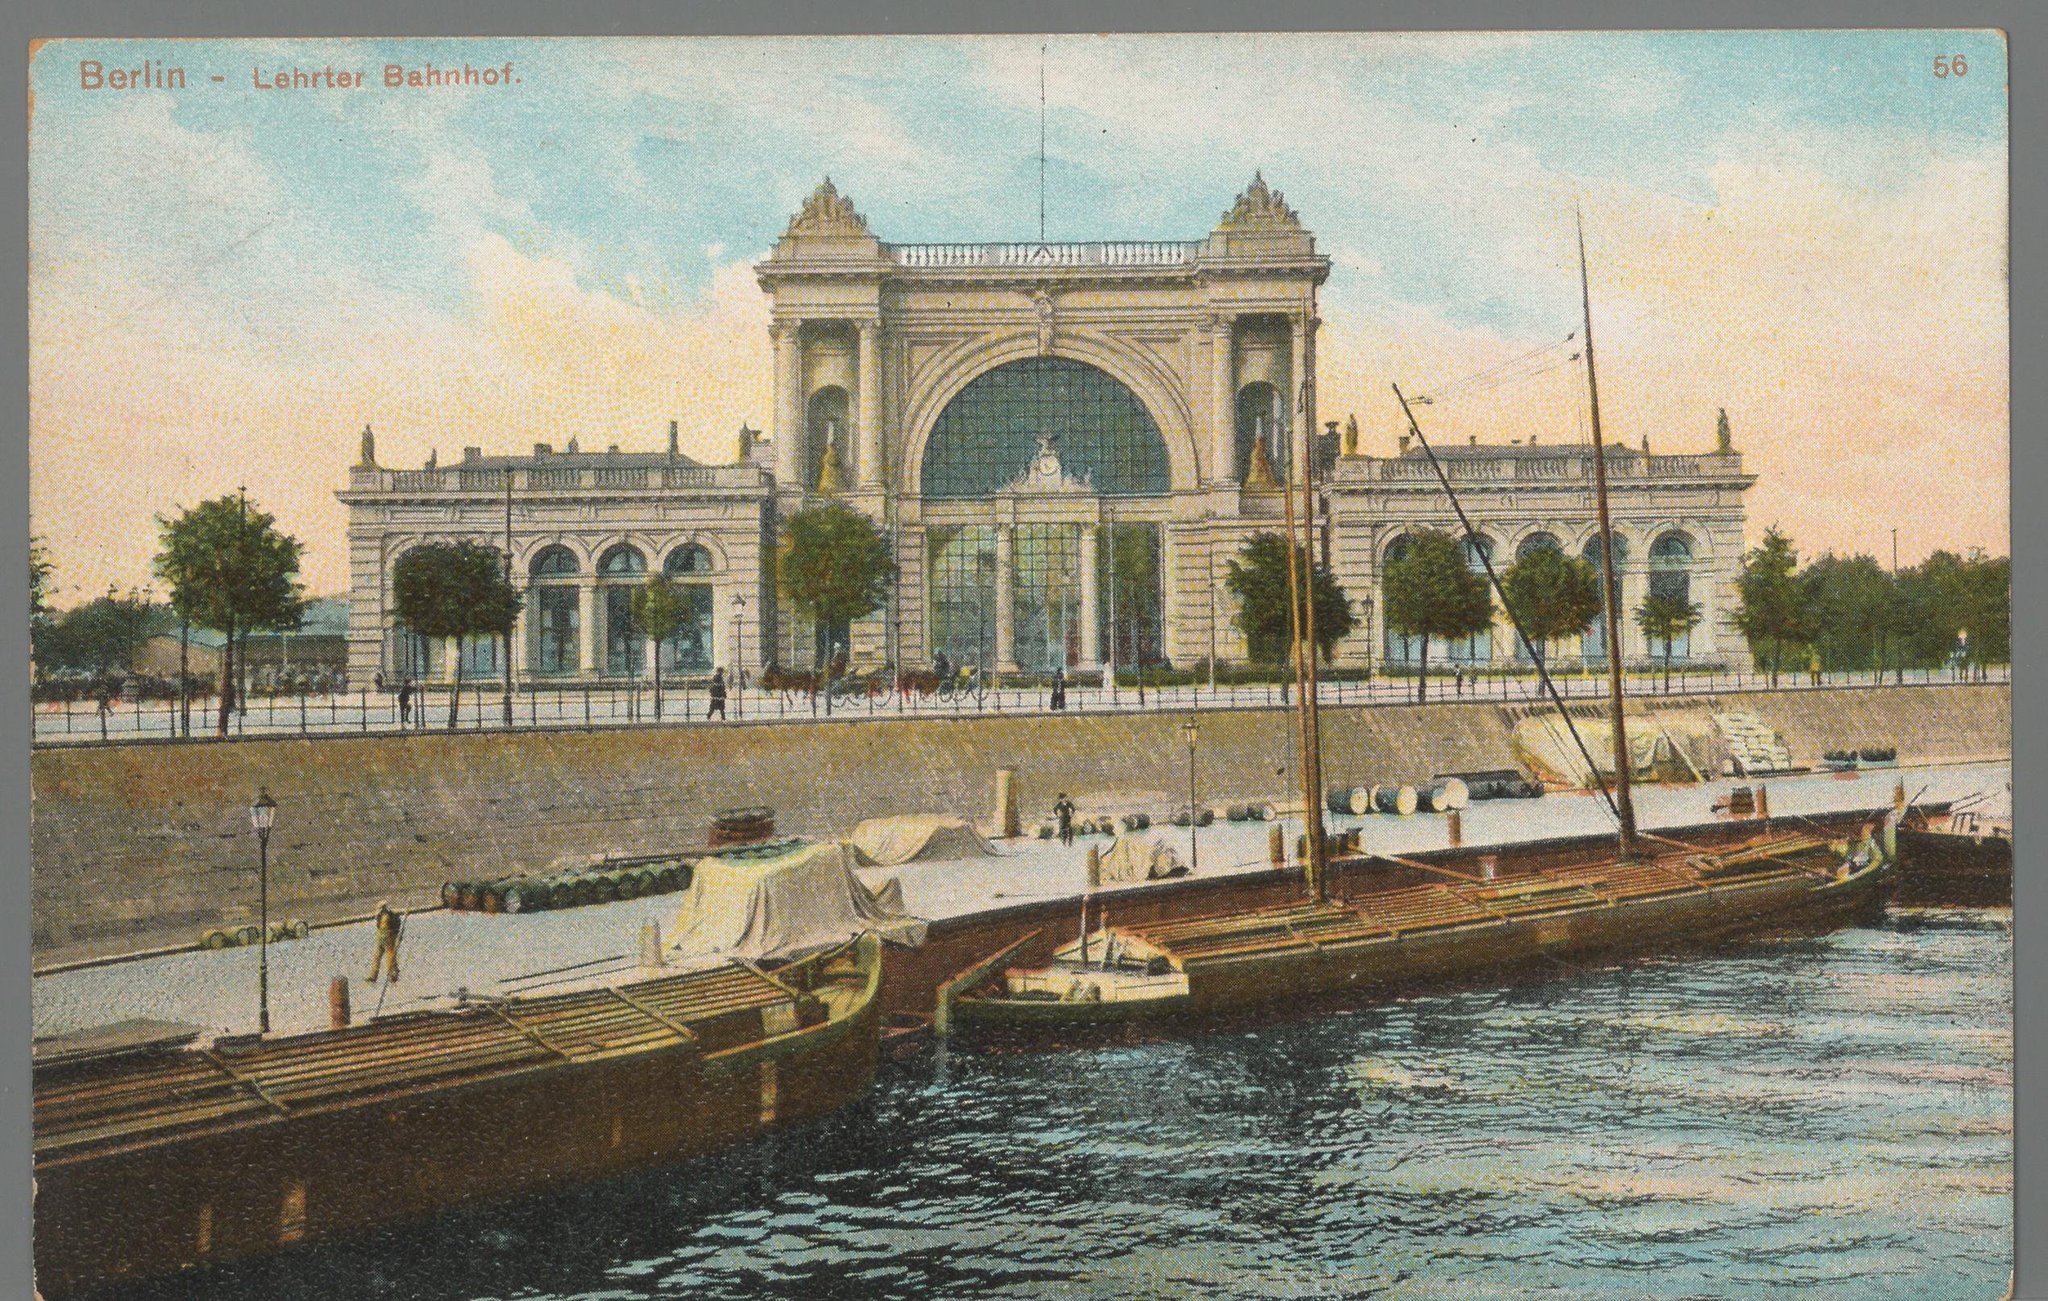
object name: ansichtkaart, prentbriefkaart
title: Berlin - Lehrter Bahnhof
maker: Anonymous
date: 1905-1930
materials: cardboard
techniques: lithograph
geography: frankfurt am main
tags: canals, waters (in city), station; shelter (railway, tramway)